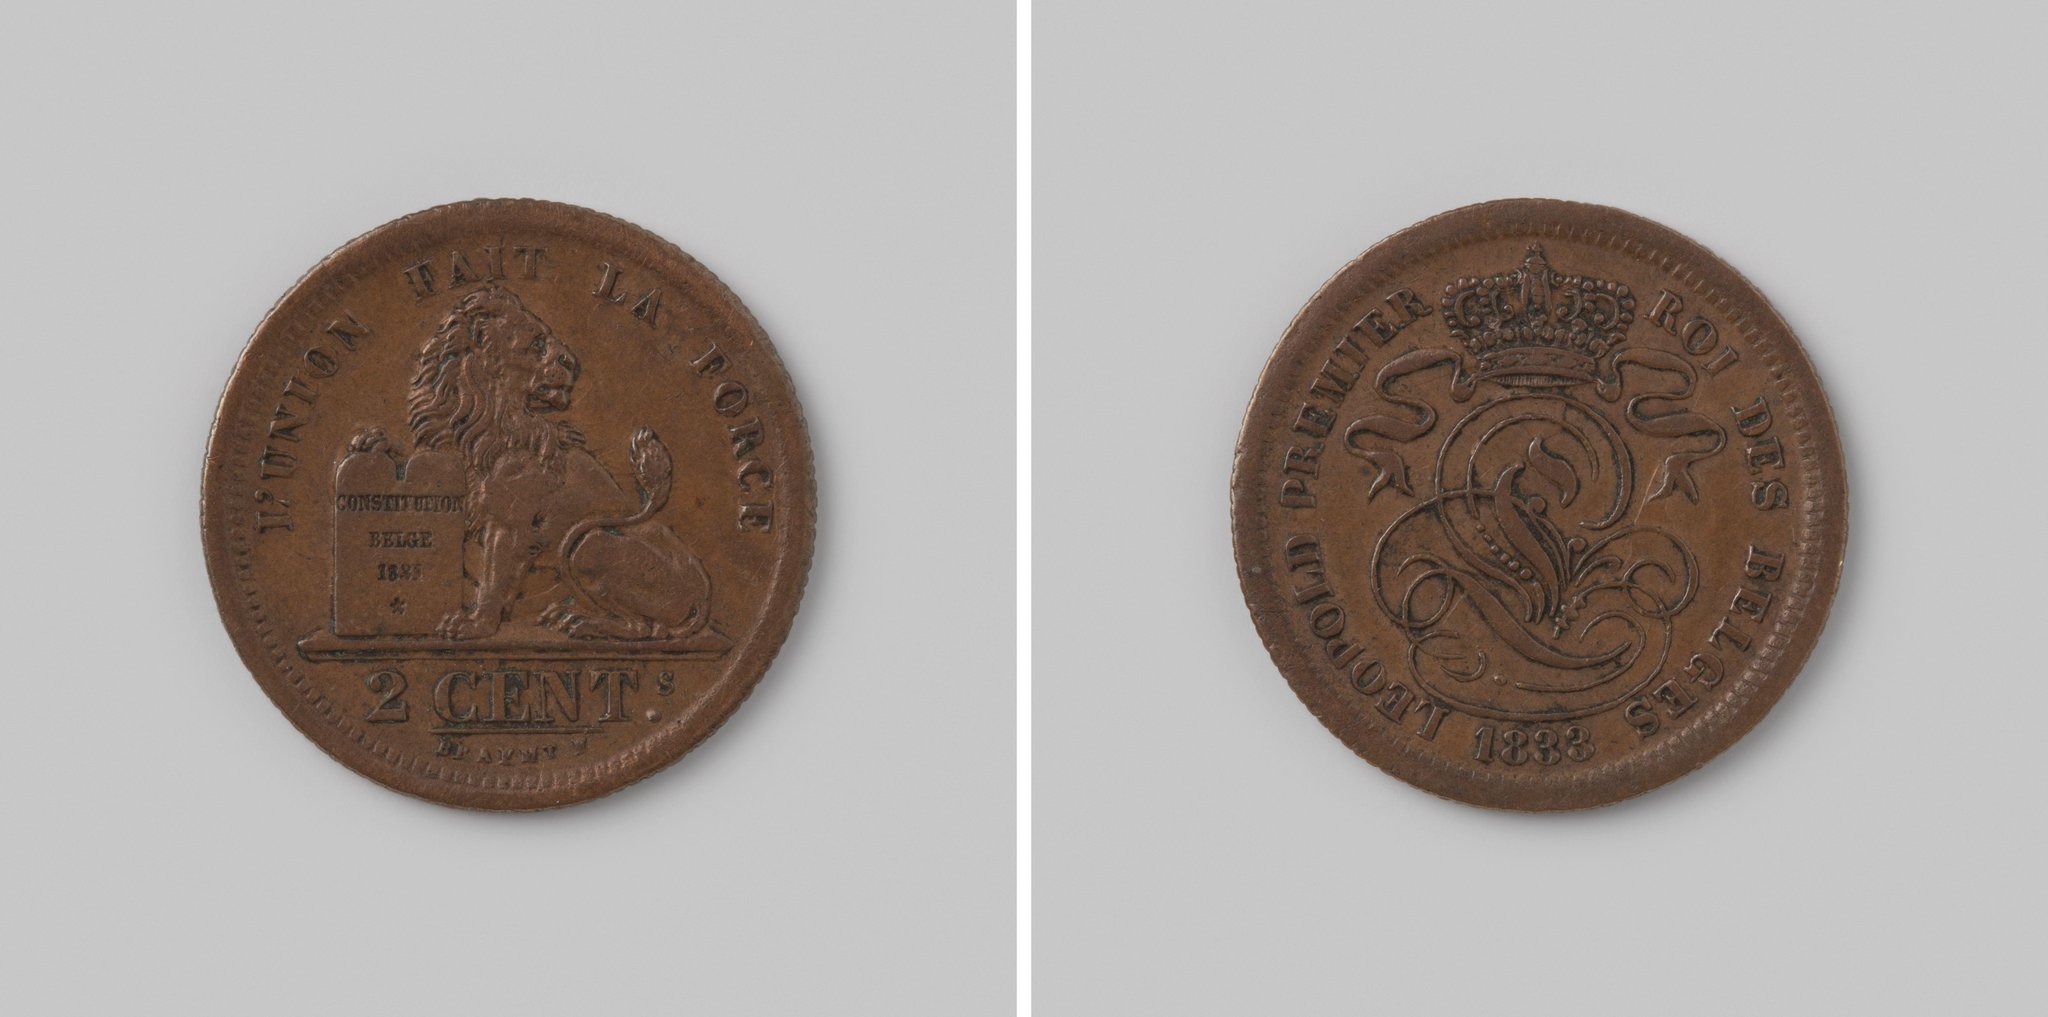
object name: cent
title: België, Leopold I, 2 centimes, 1833, op muntplaatje van Nederlandse cent.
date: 1833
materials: copper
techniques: striking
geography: brussels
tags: laeken, leopold i (koning der belgen)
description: Koperen munt. Voorzijde: zittende, omkijkende leeuw naar links met onder rechter klauw paneel met opschrift. In afsnede waarde-aanduiding. Keerzijde: gekroond monogram. Jaartal onderaan. Kartelrand. Op muntplaatje van Nederlandse cent.